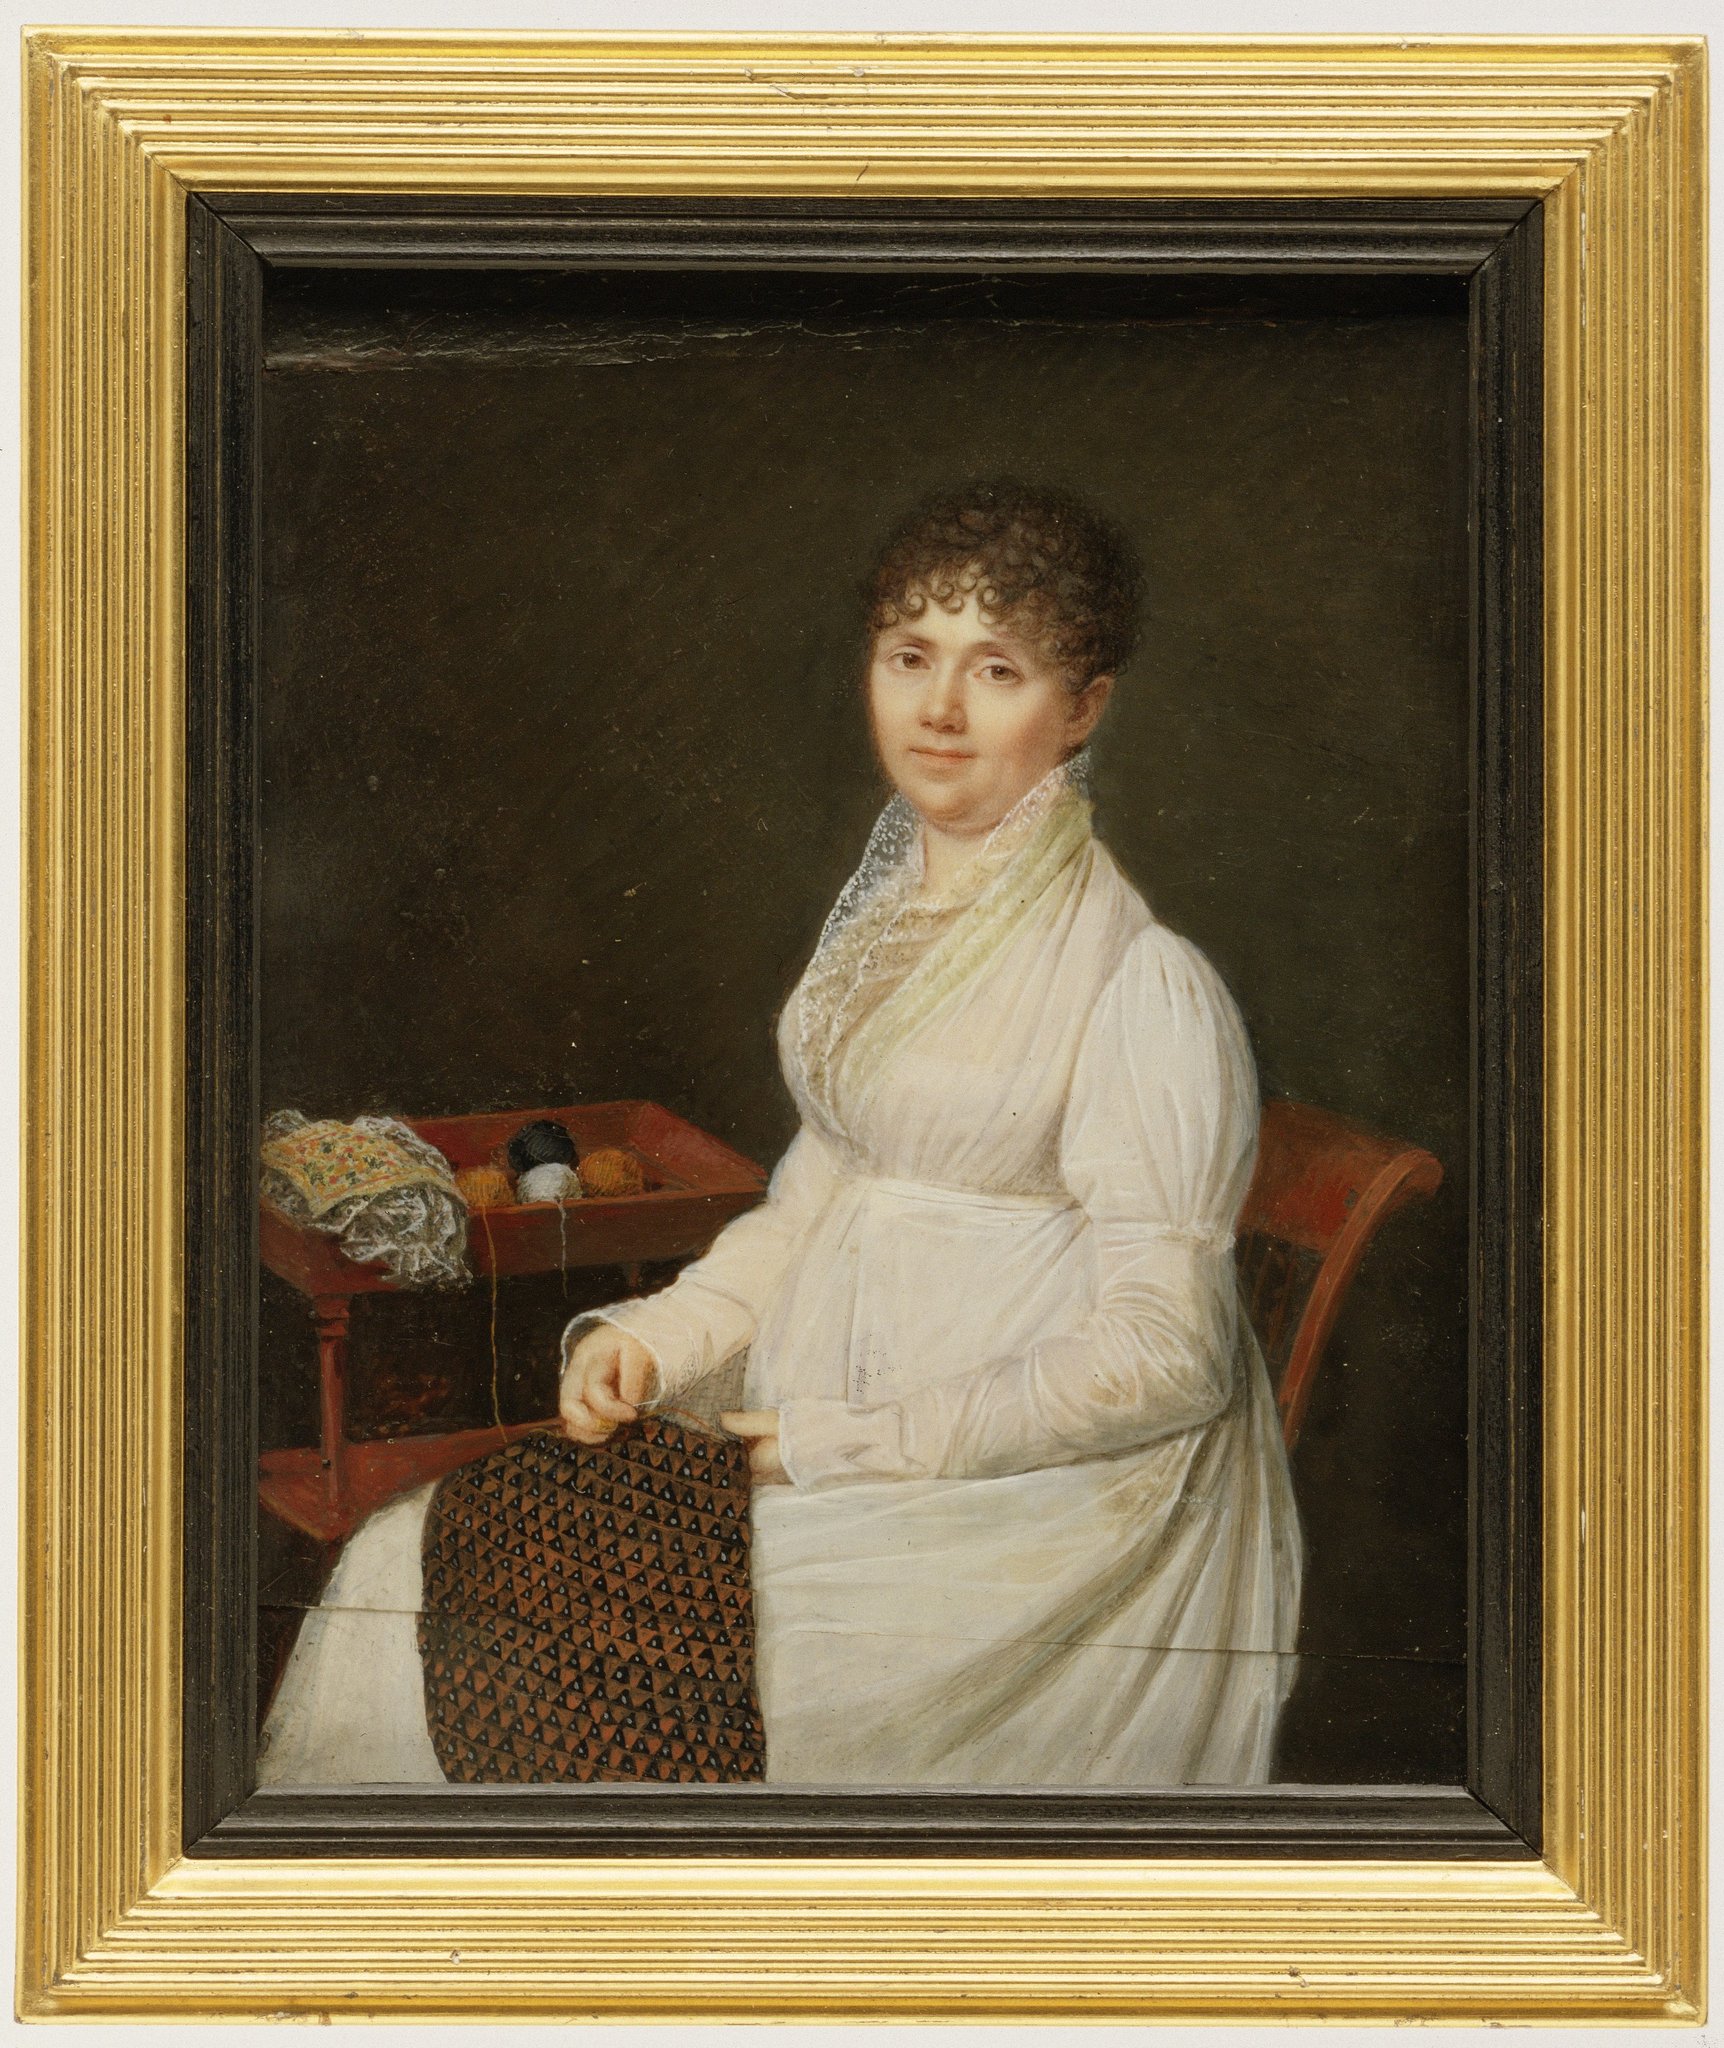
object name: painting, miniature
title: Portrait of a Woman with Tapestry Work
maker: jean-baptiste jacques augustin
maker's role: artist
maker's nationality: french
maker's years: 1759-1832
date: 1800-1810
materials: ivory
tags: portraits,women,needlework